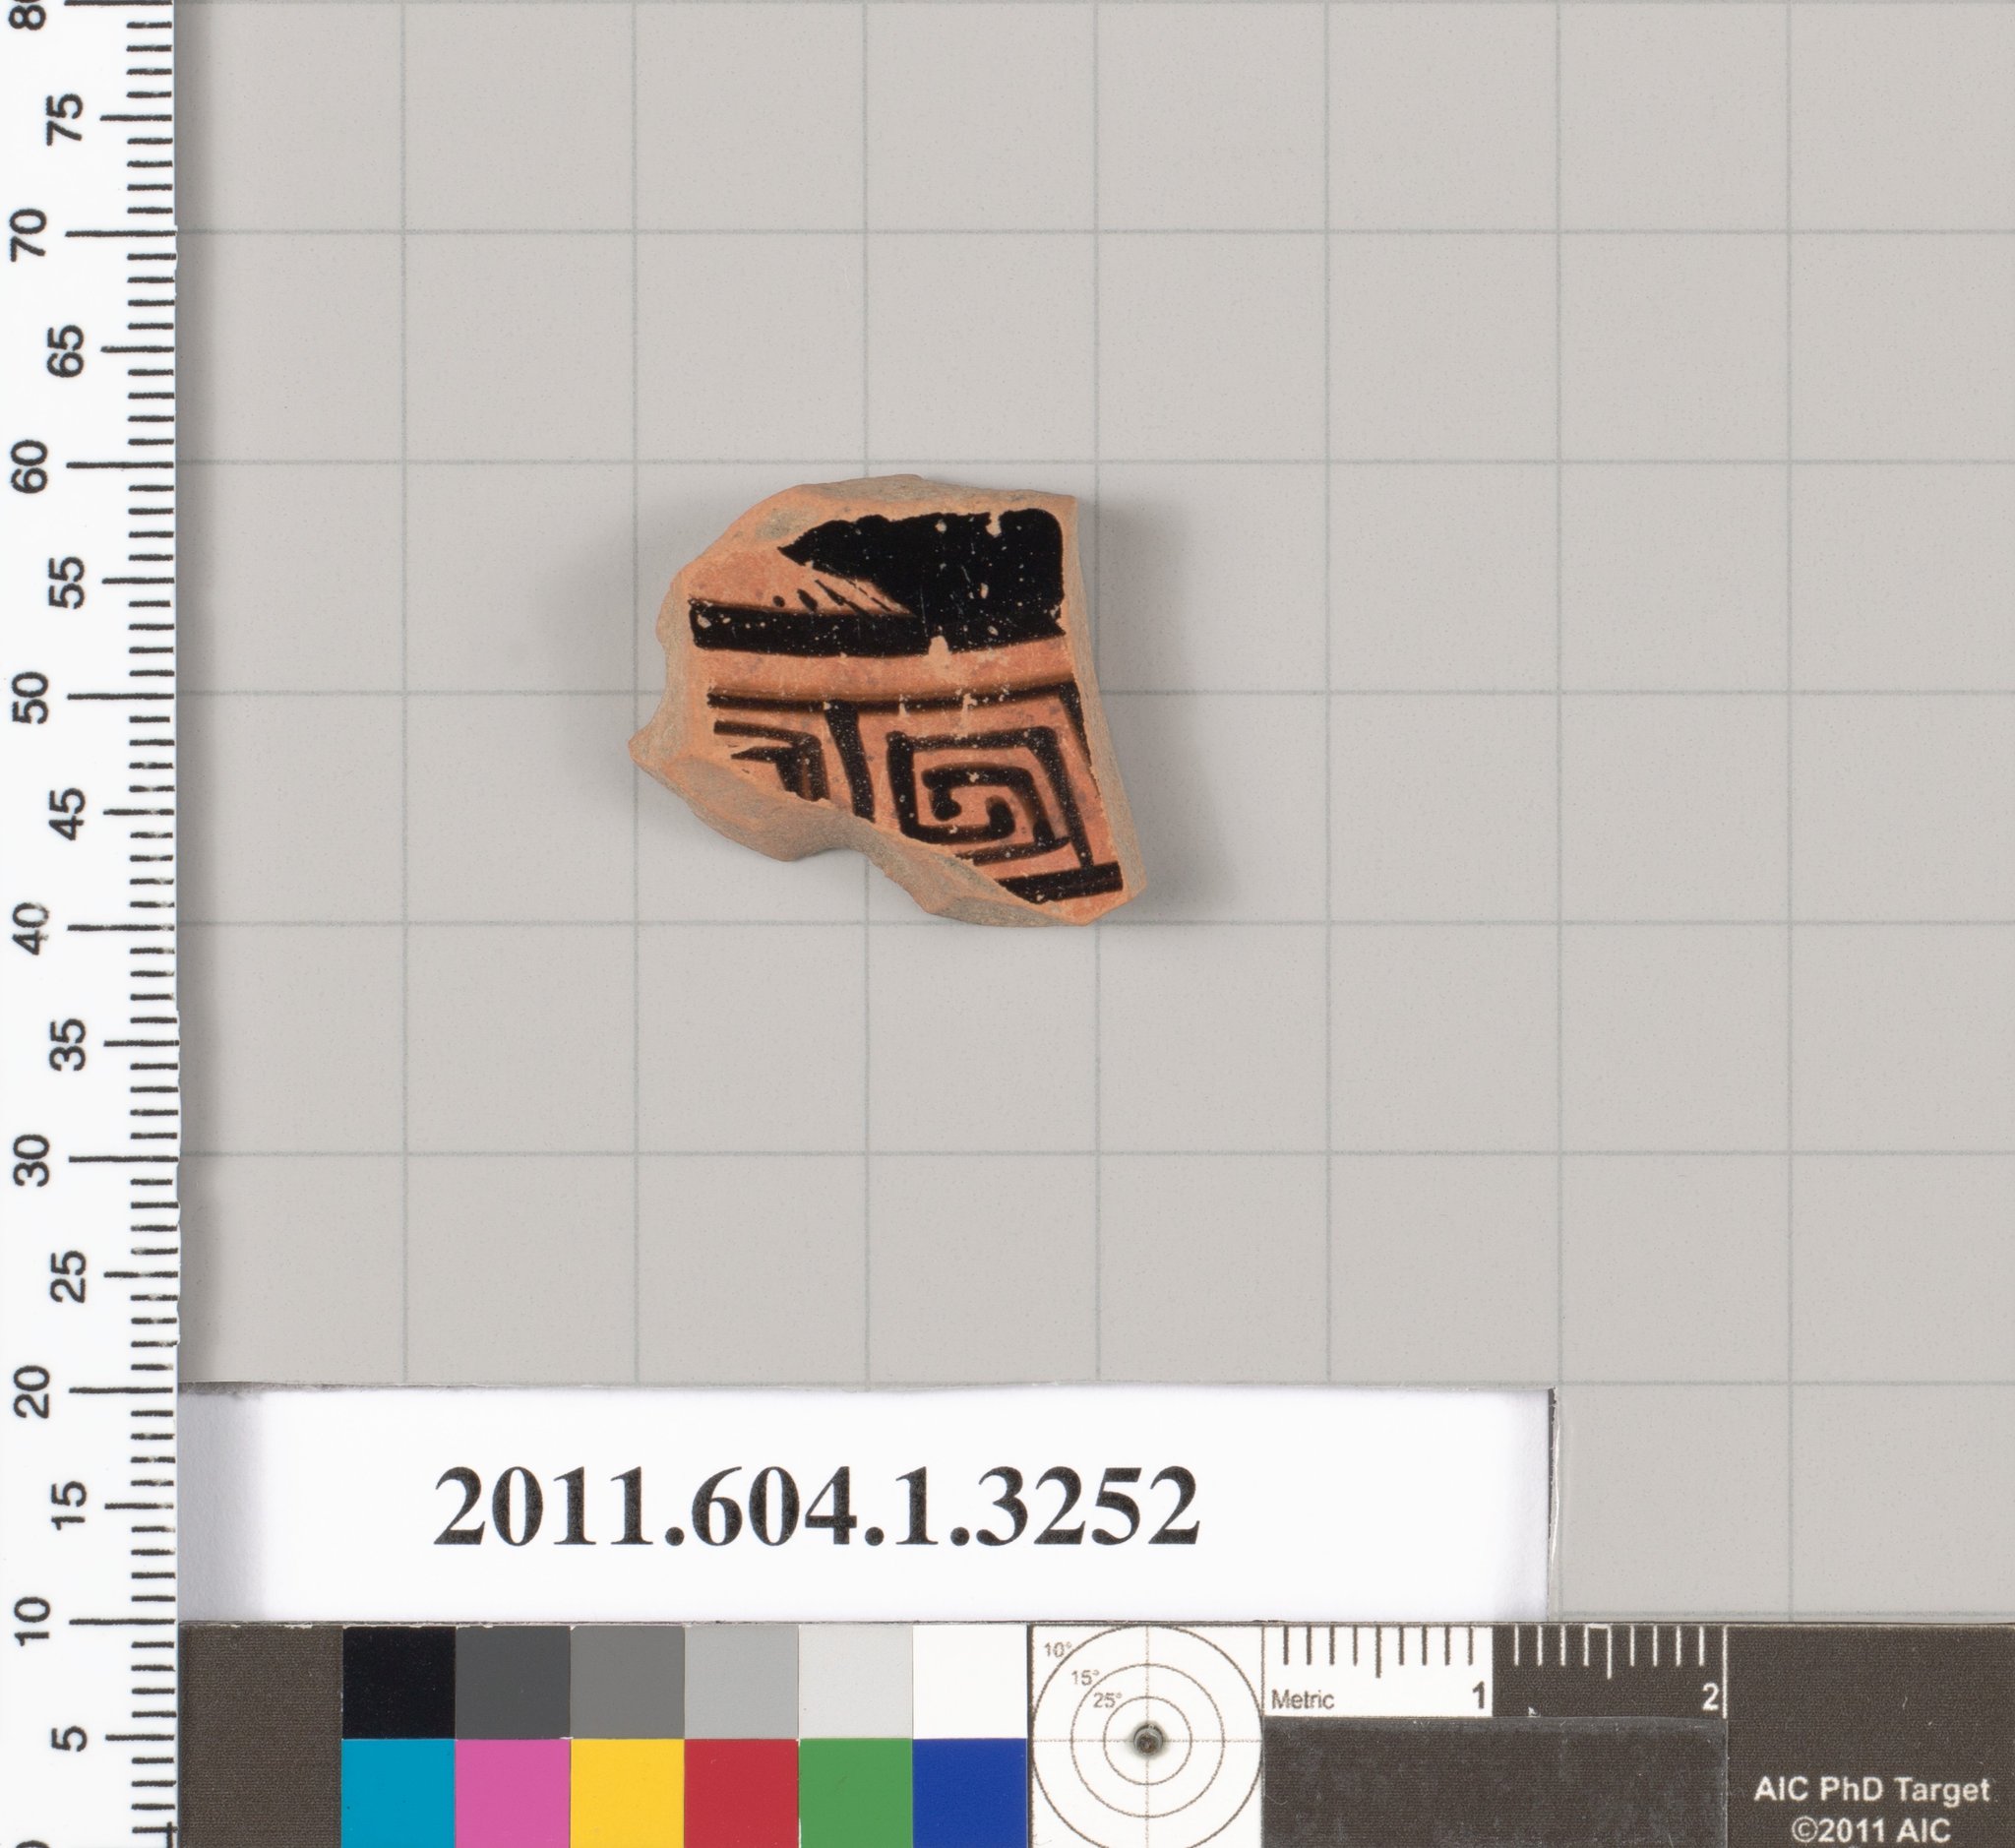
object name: kylix fragment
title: Terracotta fragment of a kylix (drinking cup)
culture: greek, attic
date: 475-451 BCE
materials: terracotta